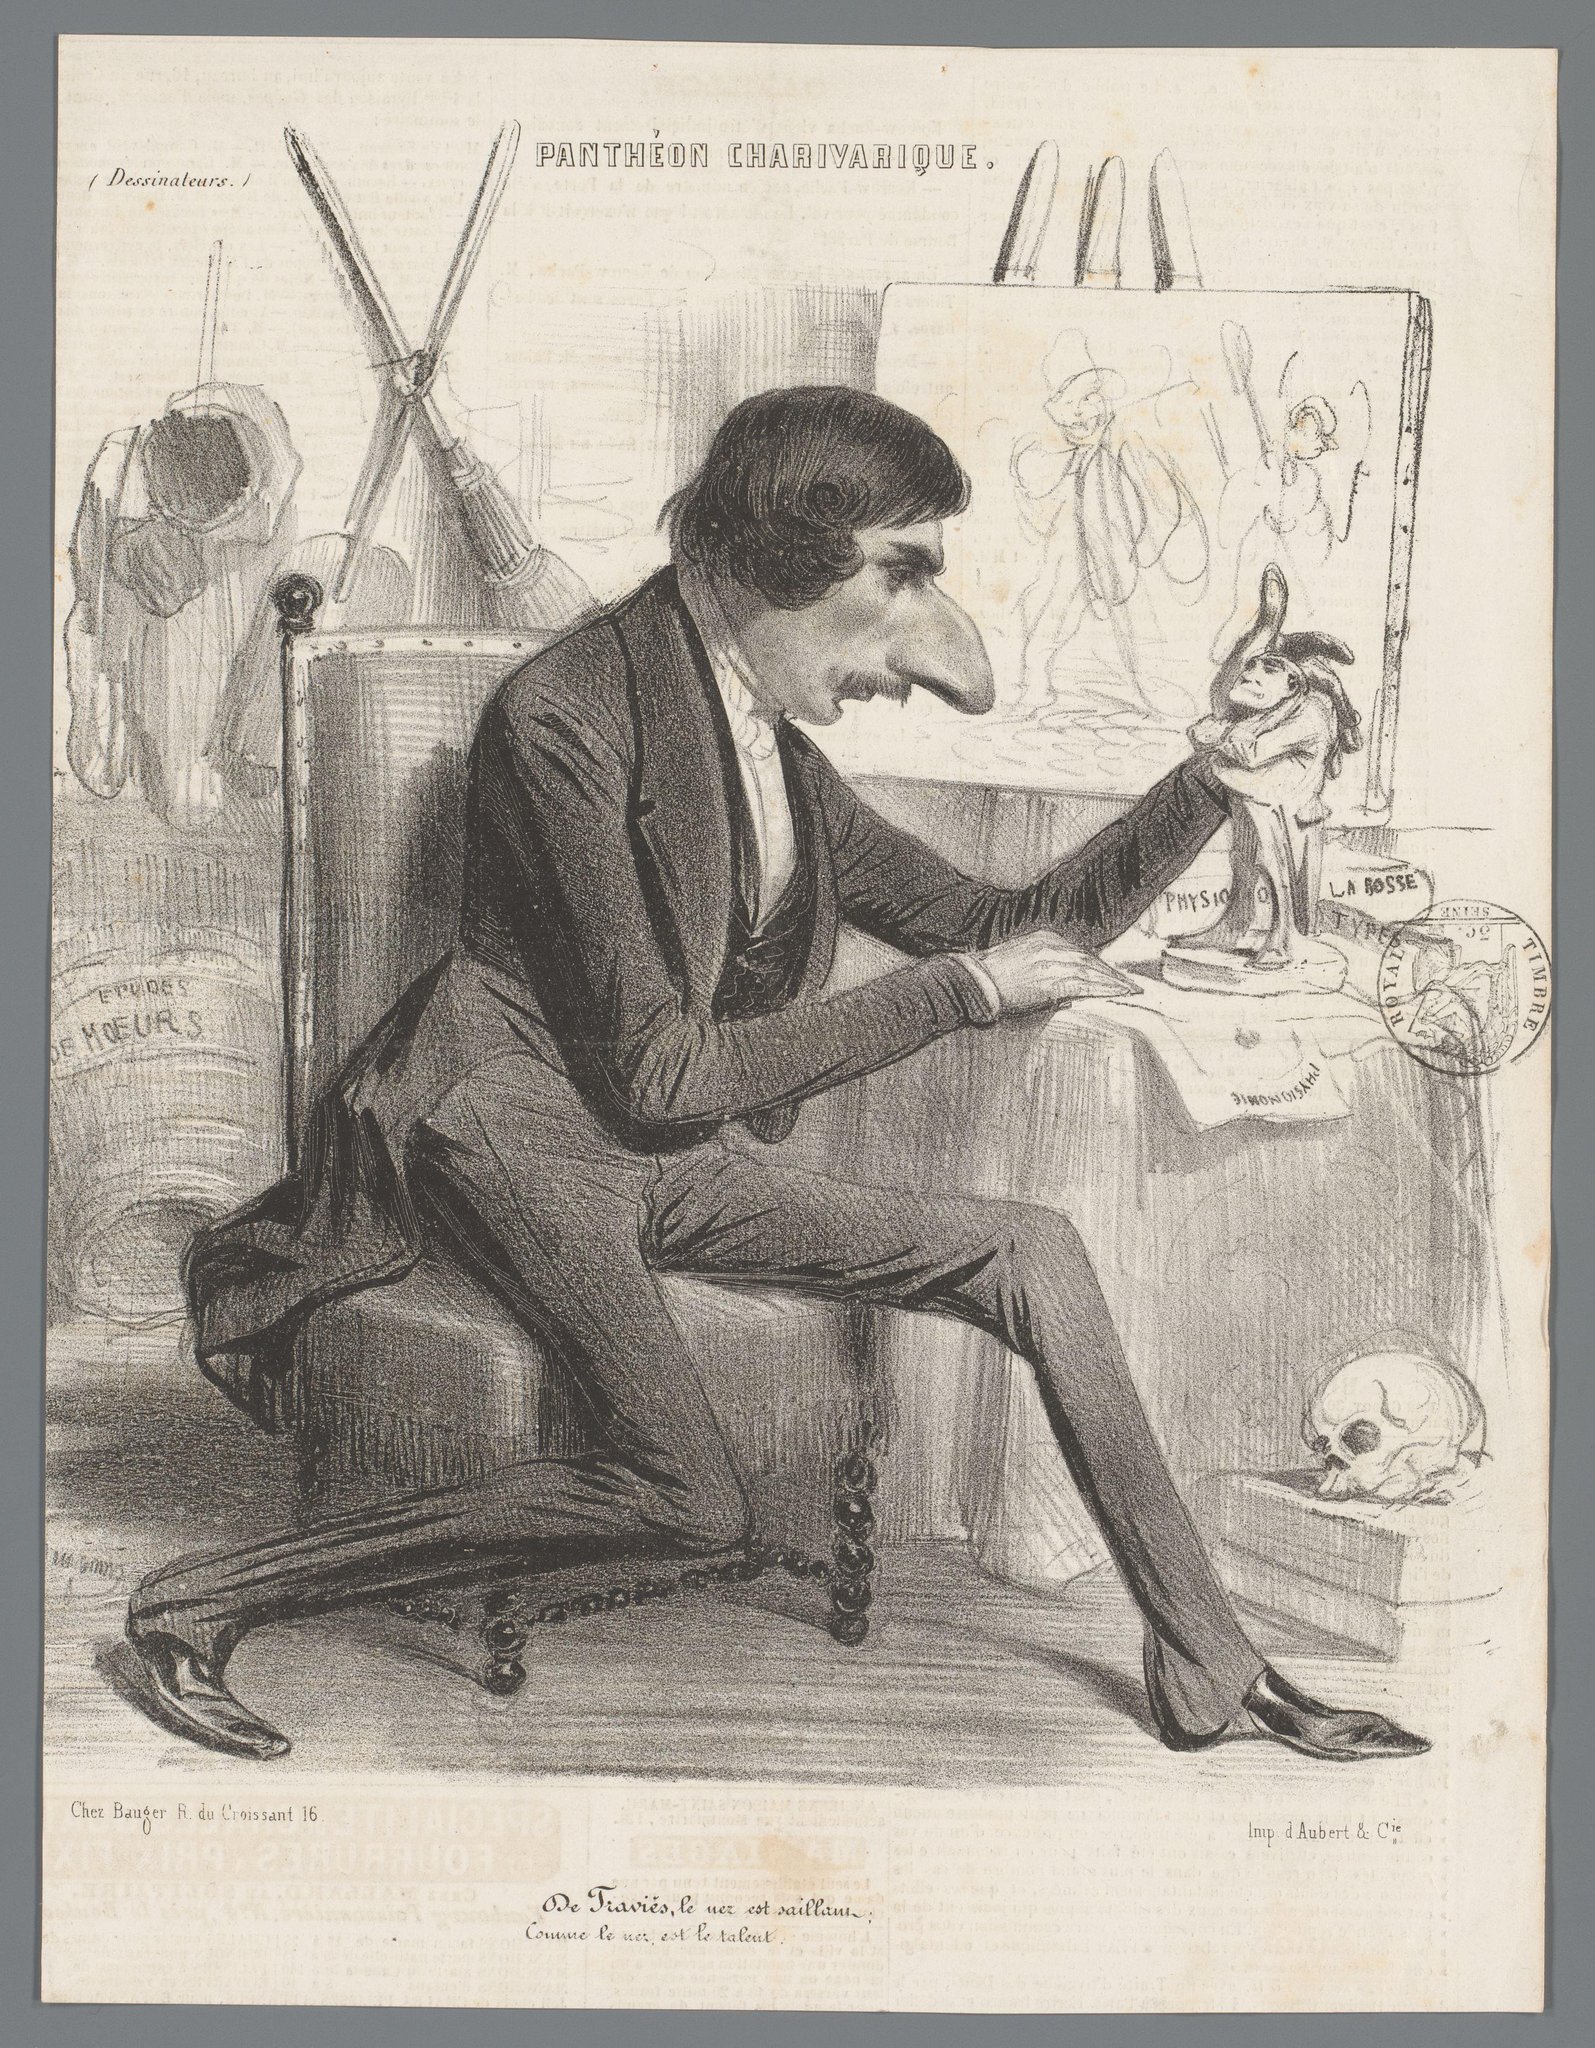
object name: cartoon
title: Karikaturen van bekende personen uit Le Charivari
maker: benjamin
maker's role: print maker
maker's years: 1811-1847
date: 1838-1842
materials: paper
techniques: letterpress printing, lithograph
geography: paris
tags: paris, print maker, charles-joseph traviès, caricatures (human types), artist at work, in his workshop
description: Prent uit: Le Charivari. Publicatiedetails voor deze specifieke prent onbekend.